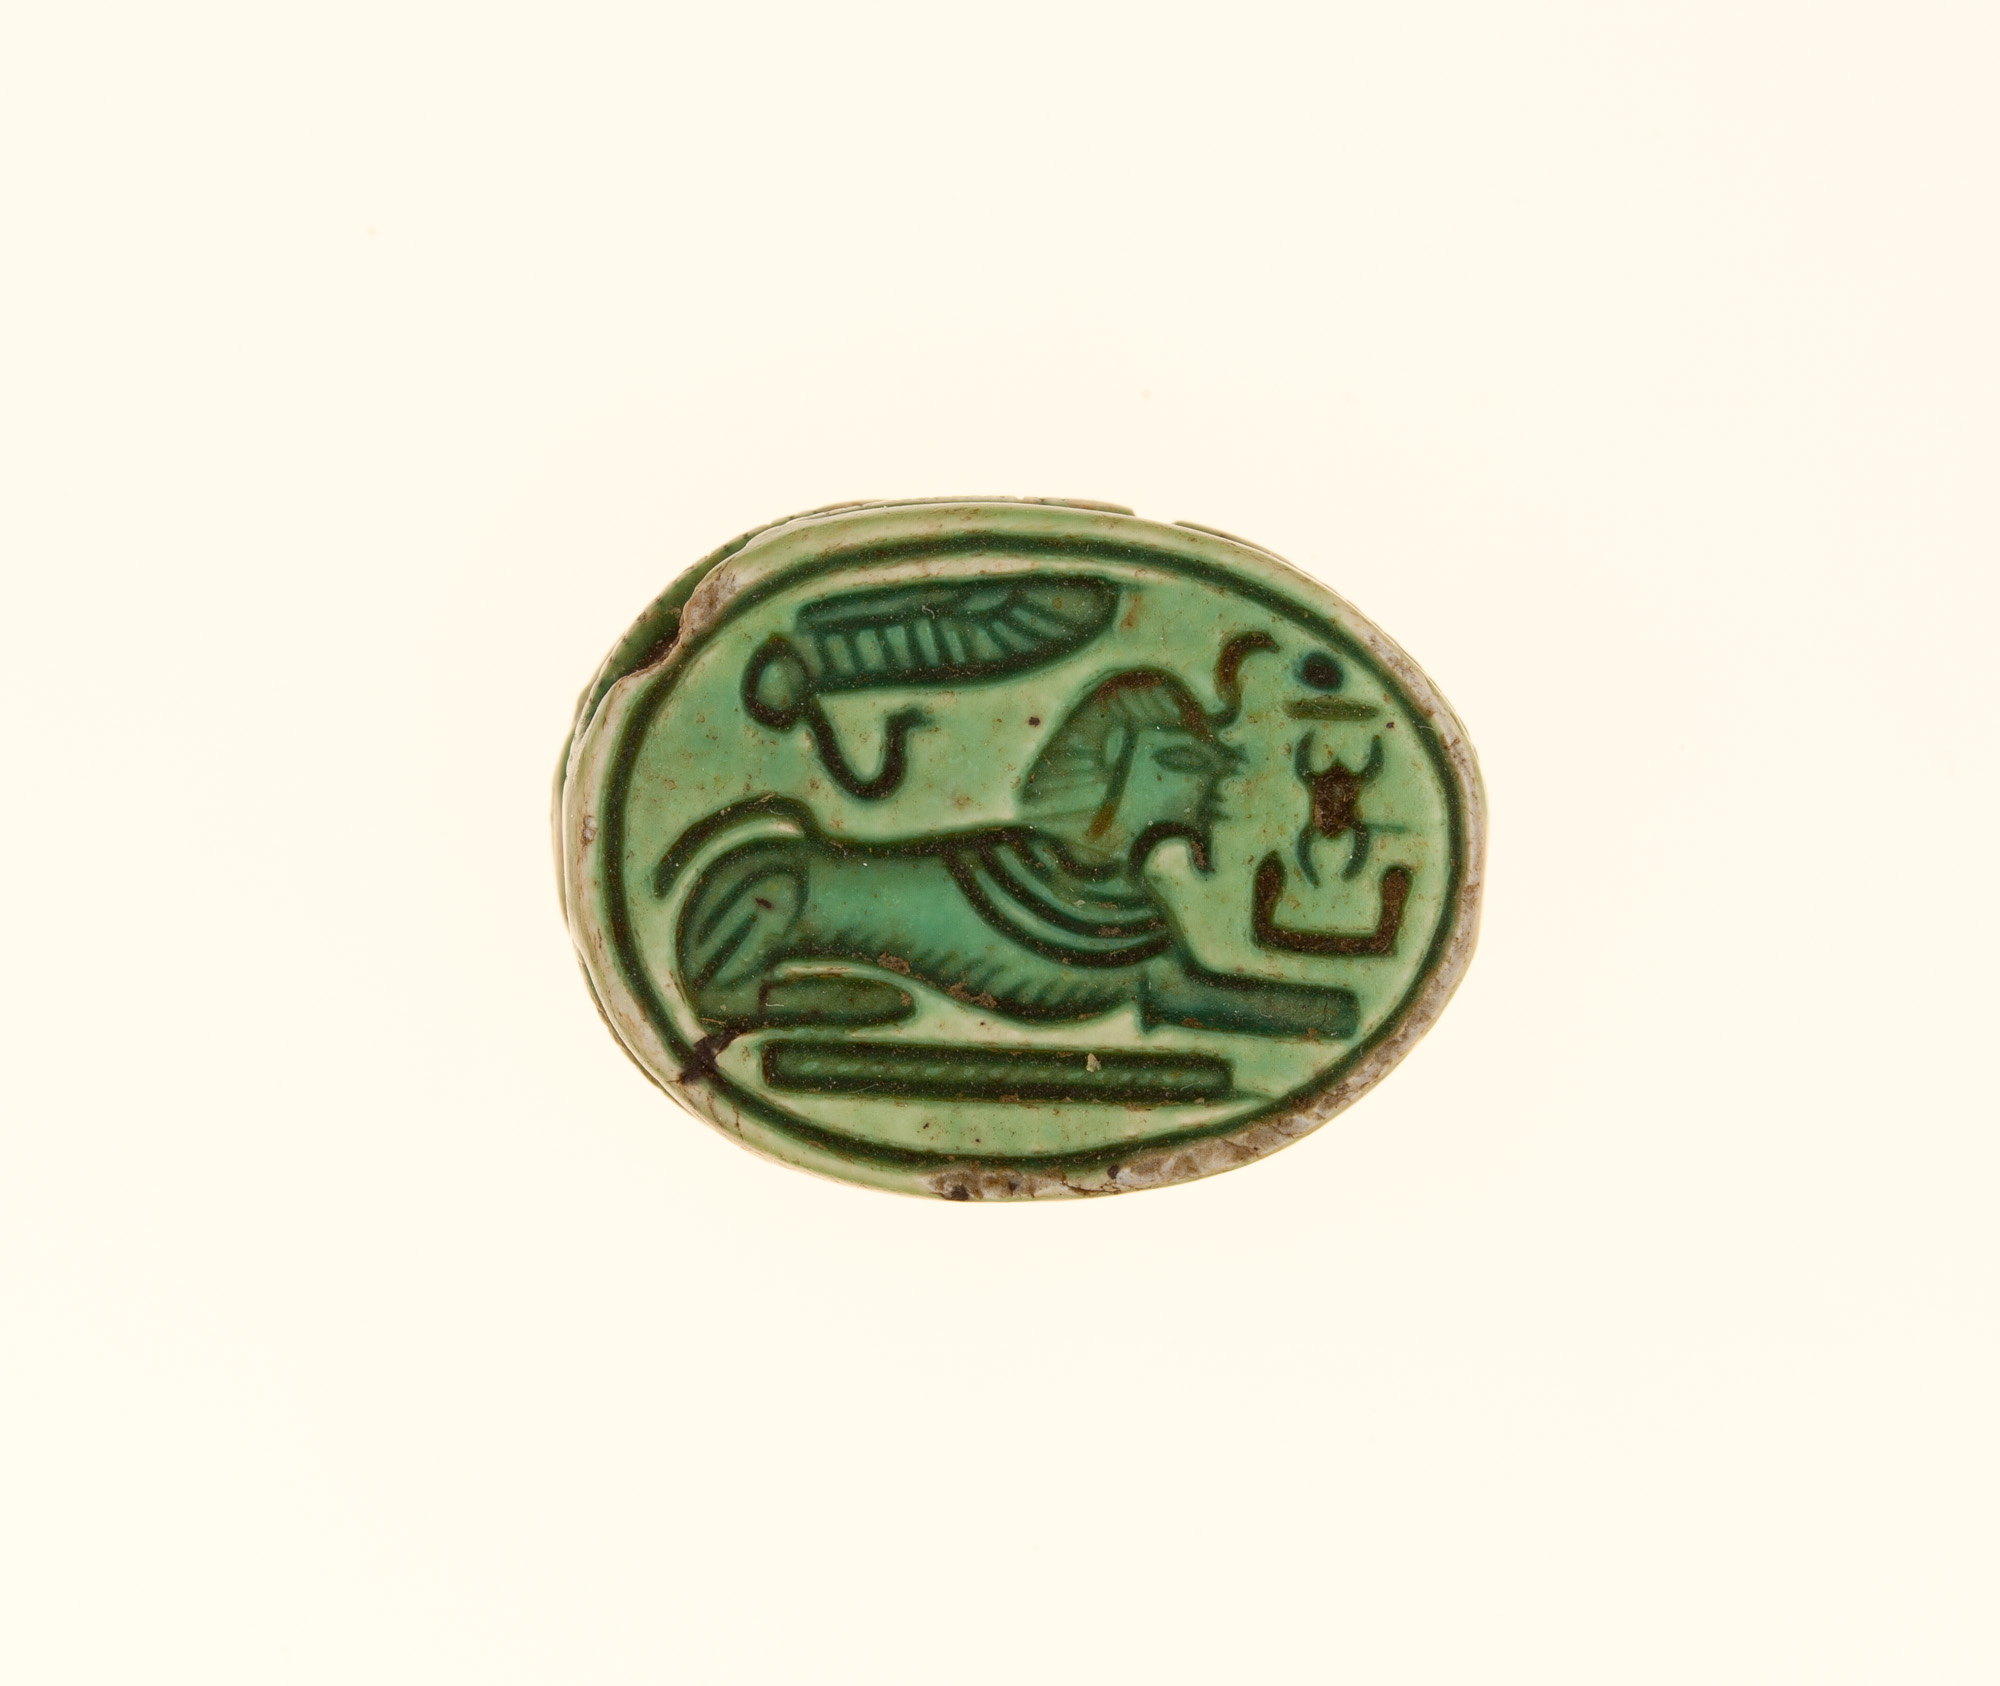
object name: scarab, thutmose i, aakheperkare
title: Scarab Inscribed With the Name Aakheperkare (Thutmose I)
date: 1504-1492 BCE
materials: stone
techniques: glazing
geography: egypt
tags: sphinx,scarabs